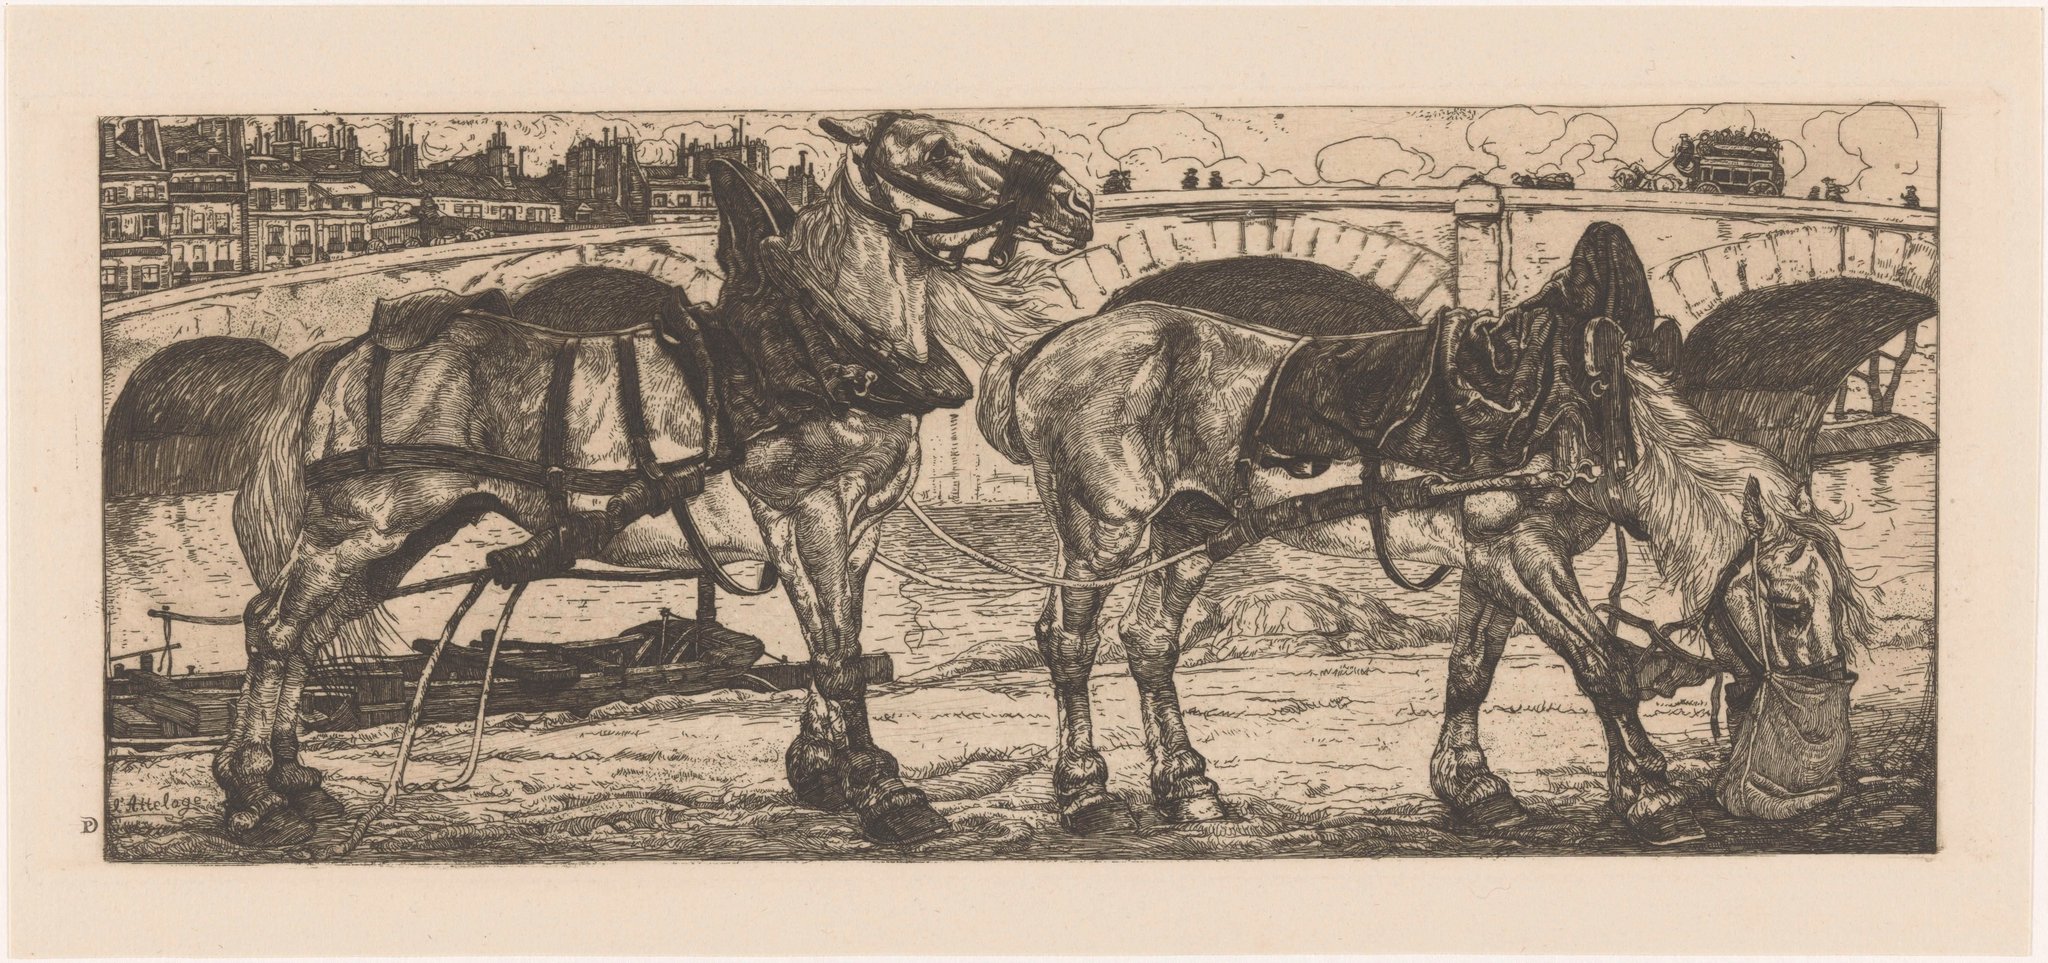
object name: print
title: L'Attelage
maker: pieter dupont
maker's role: draughtsman, print maker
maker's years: 1870-1911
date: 1899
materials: paper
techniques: etching, intaglio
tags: diligence, omnibus, horse-tram, horse, bridge in city across river, canal, etc., paris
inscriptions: collector's mark: Lugt 2233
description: Eén van de paarden eet uit een haverzak. Op de achtergrond een brug over de Seine met daarop een paardentram.